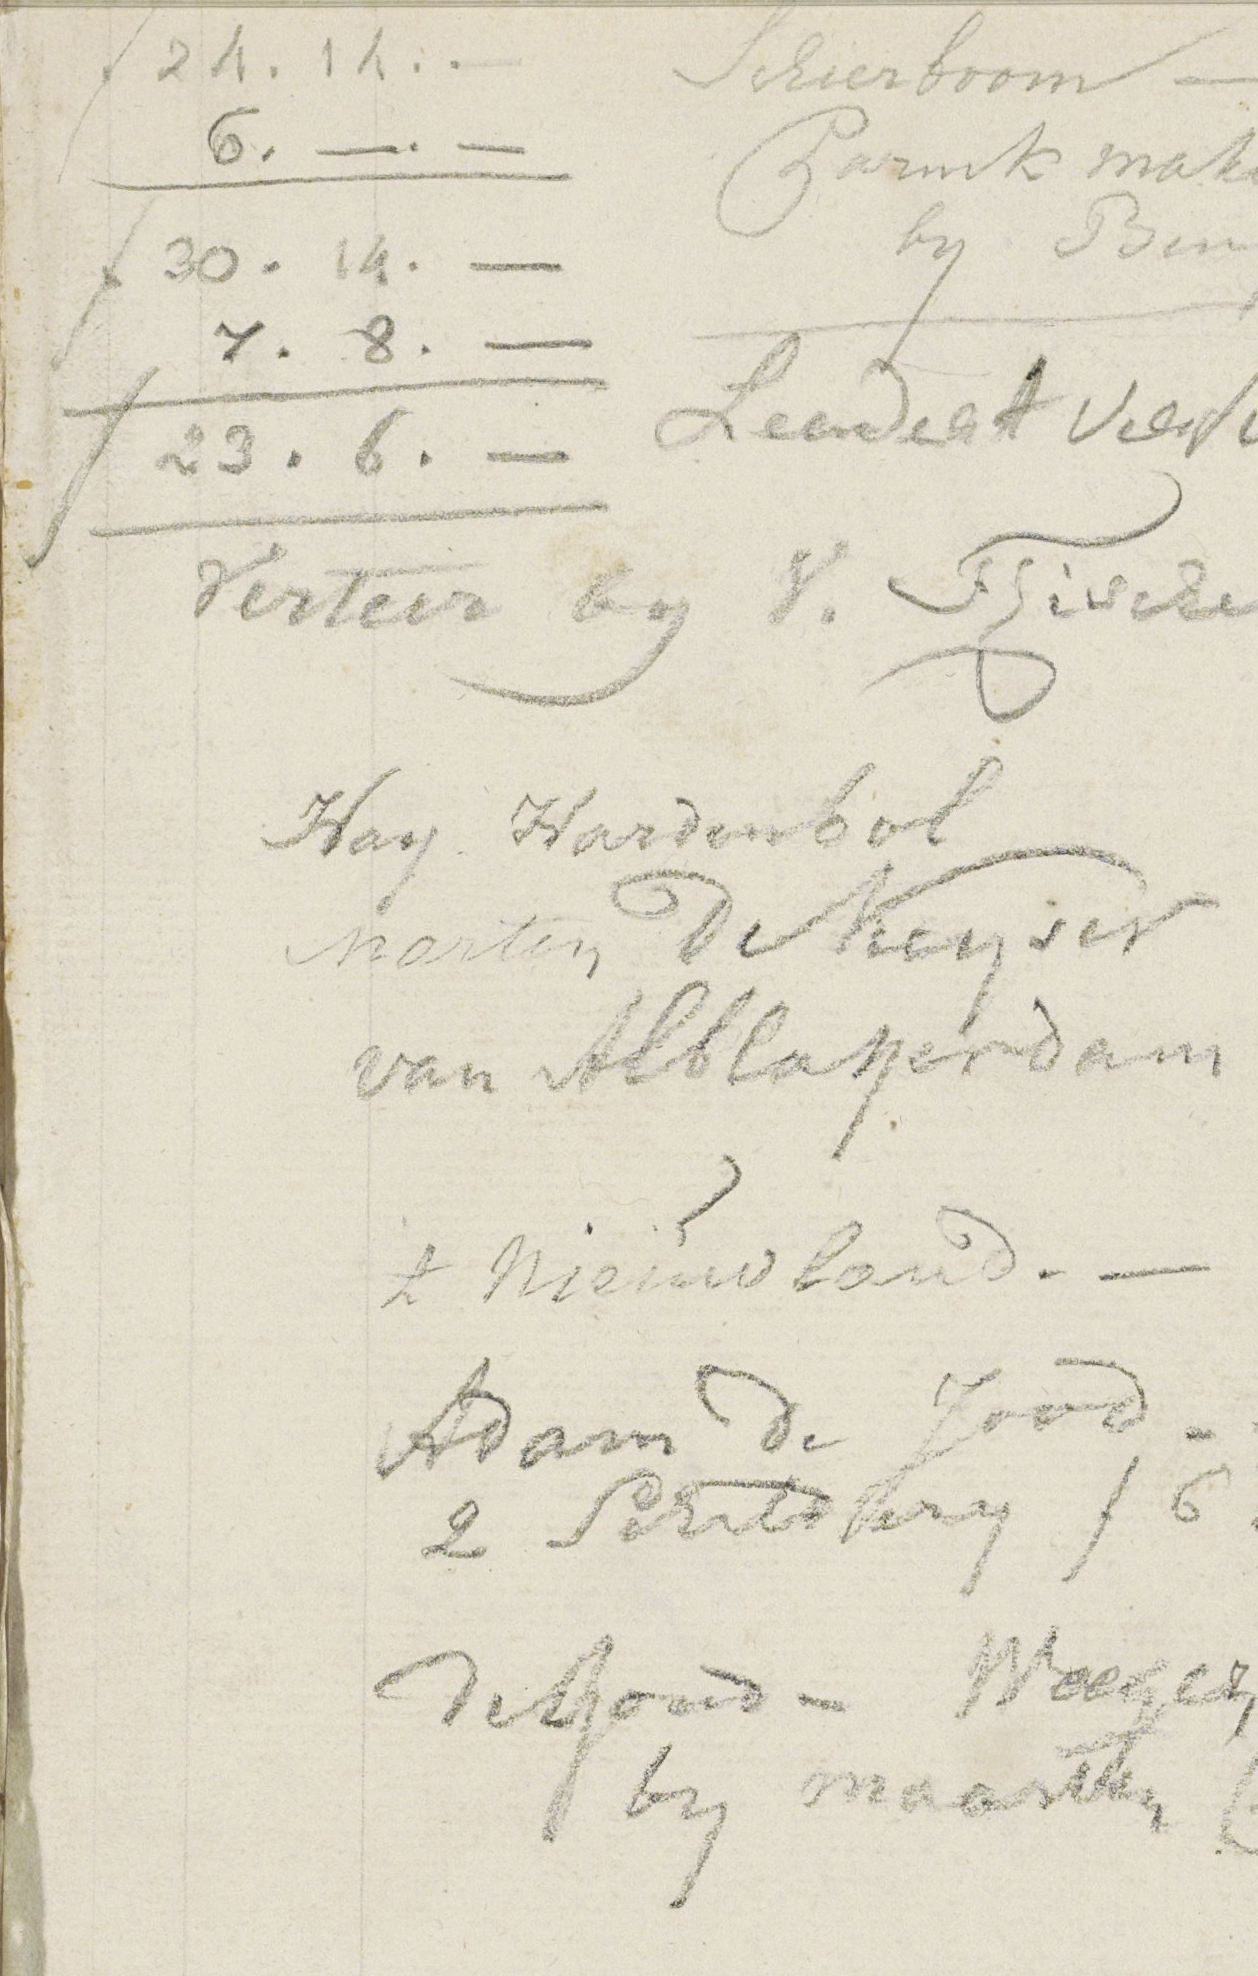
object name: sketchbook leaf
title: Notities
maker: jacob perkois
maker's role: draughtsman, print maker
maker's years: 1756-1804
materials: paper, pencil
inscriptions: annotation: ‘[...]’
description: Bladzijde 77 uit een schetsboek met 78 bladzijden.